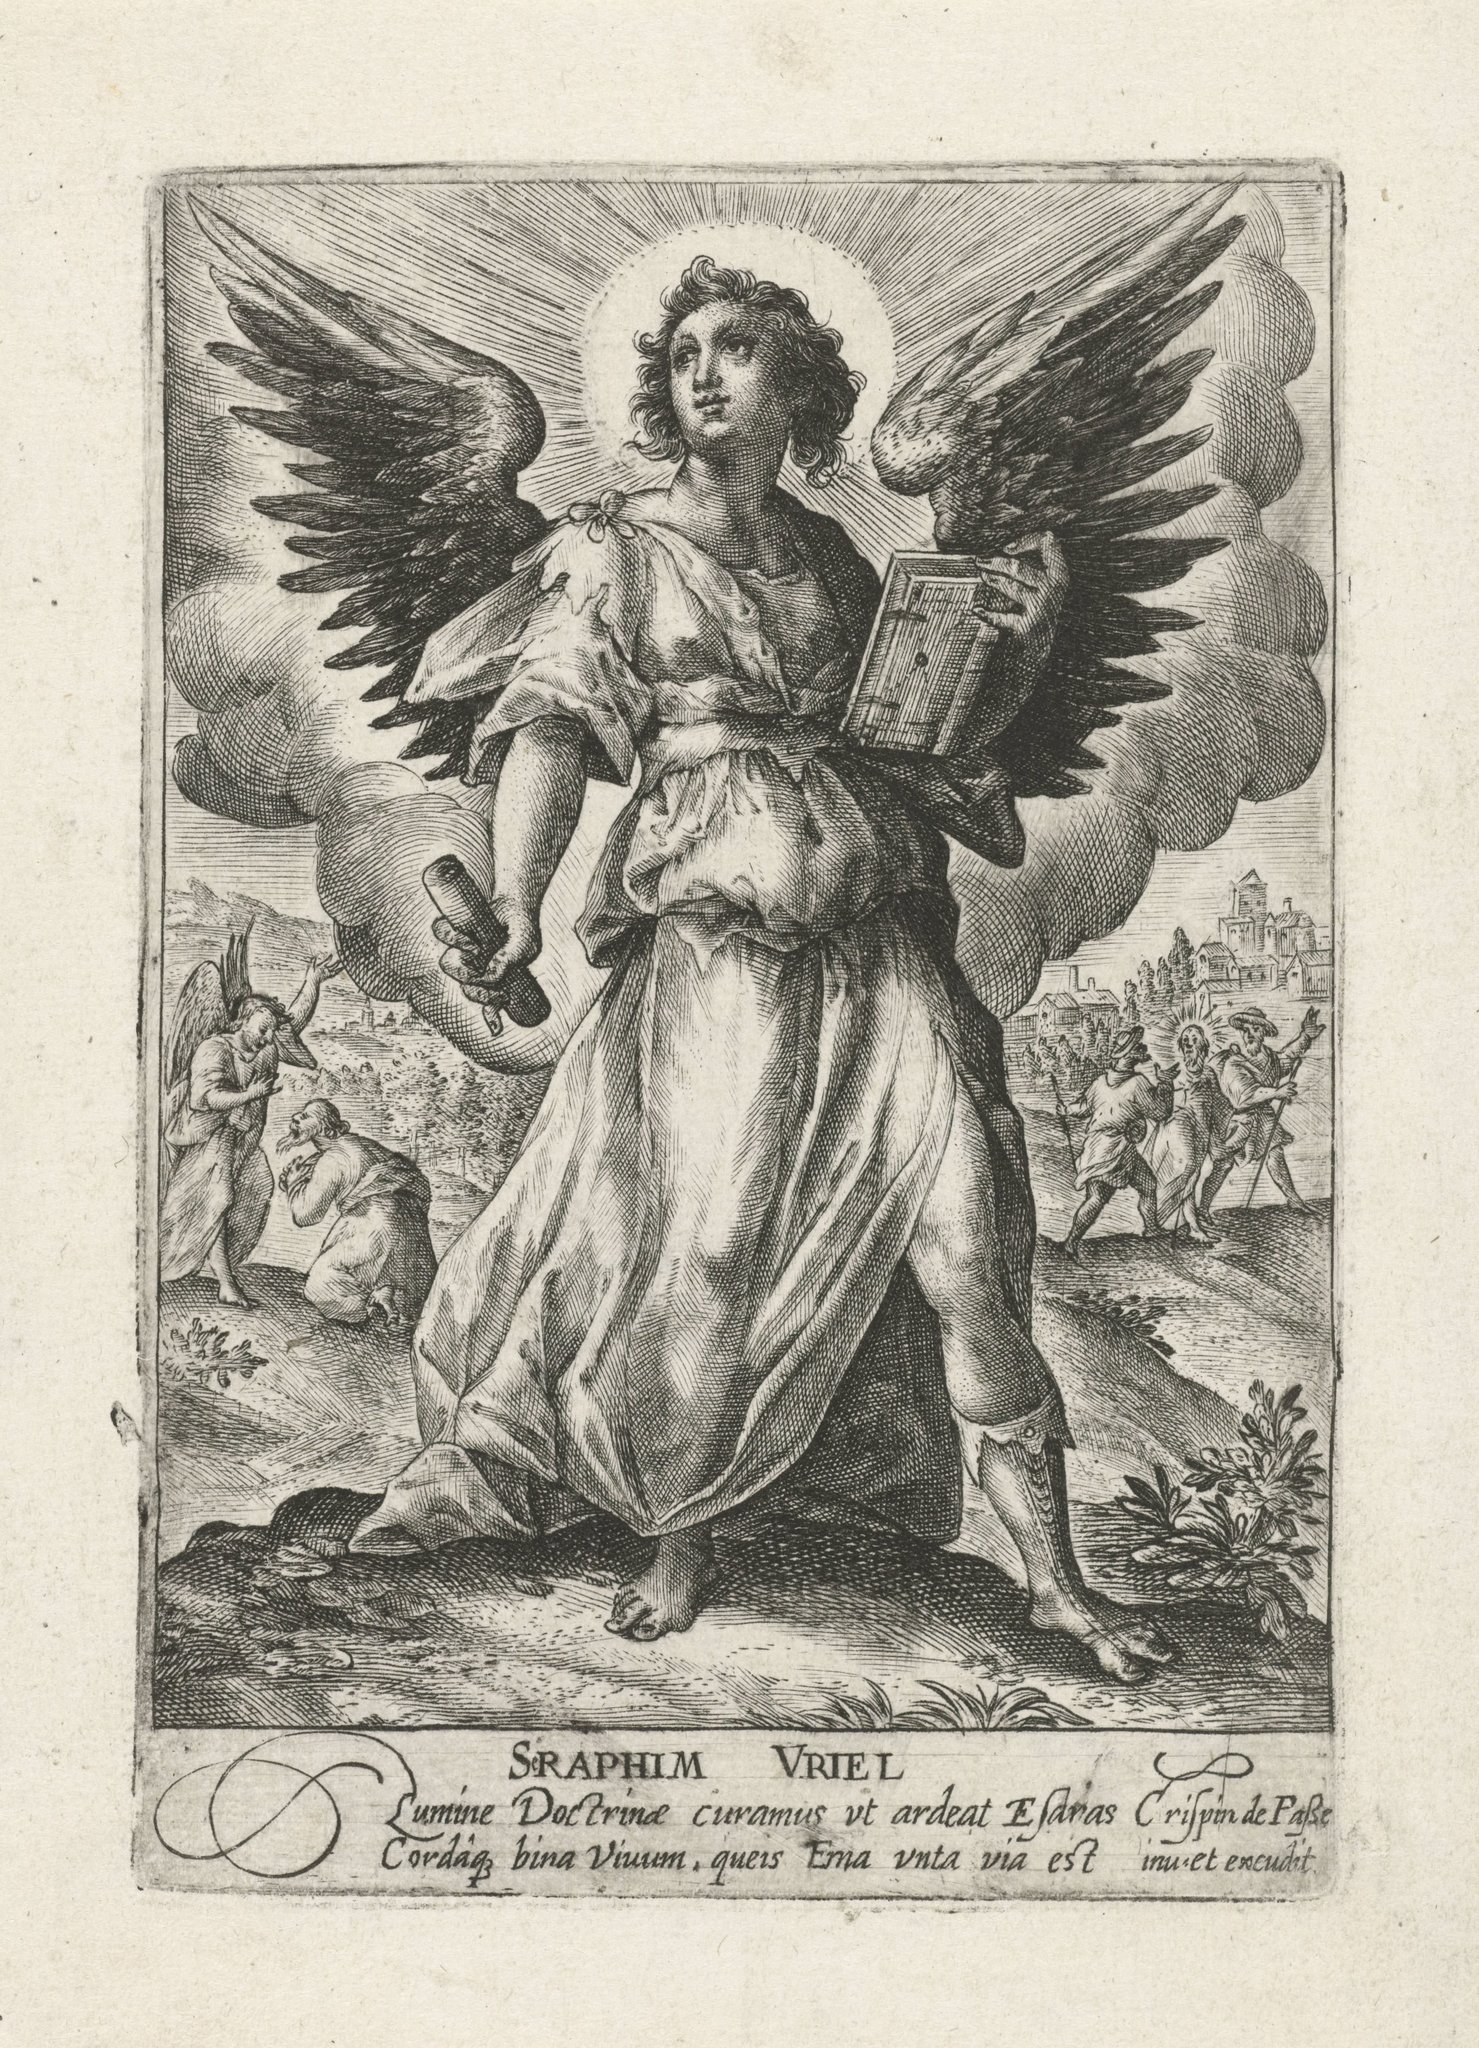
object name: print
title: Aartsengelen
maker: crispijn van de passe (i)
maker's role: draughtsman, print maker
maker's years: 1564-1637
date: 1574-1637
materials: paper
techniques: engraving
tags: other archangels than michael, gabriel and raphael: uriel, cleopas and peter meet christ (sometimes they are dressed as pilgrims), ezra and the archangel uriel (2 esdras 4:1)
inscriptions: collector's mark: Lugt 2228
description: De aartsengel Uriël staat met een boek in zijn linkerhand en een opgerold vel papier in zijn rechterhand. Links op de achtergrond berispt Uriël de priester Ezra. Rechts op de achtergrond de twee discipelen die Christus ontmoeten op hun weg naar Emmaüs. In de marge een tweeregelig onderschrift in het Latijn. Prent uit een serie met aartsengelen.